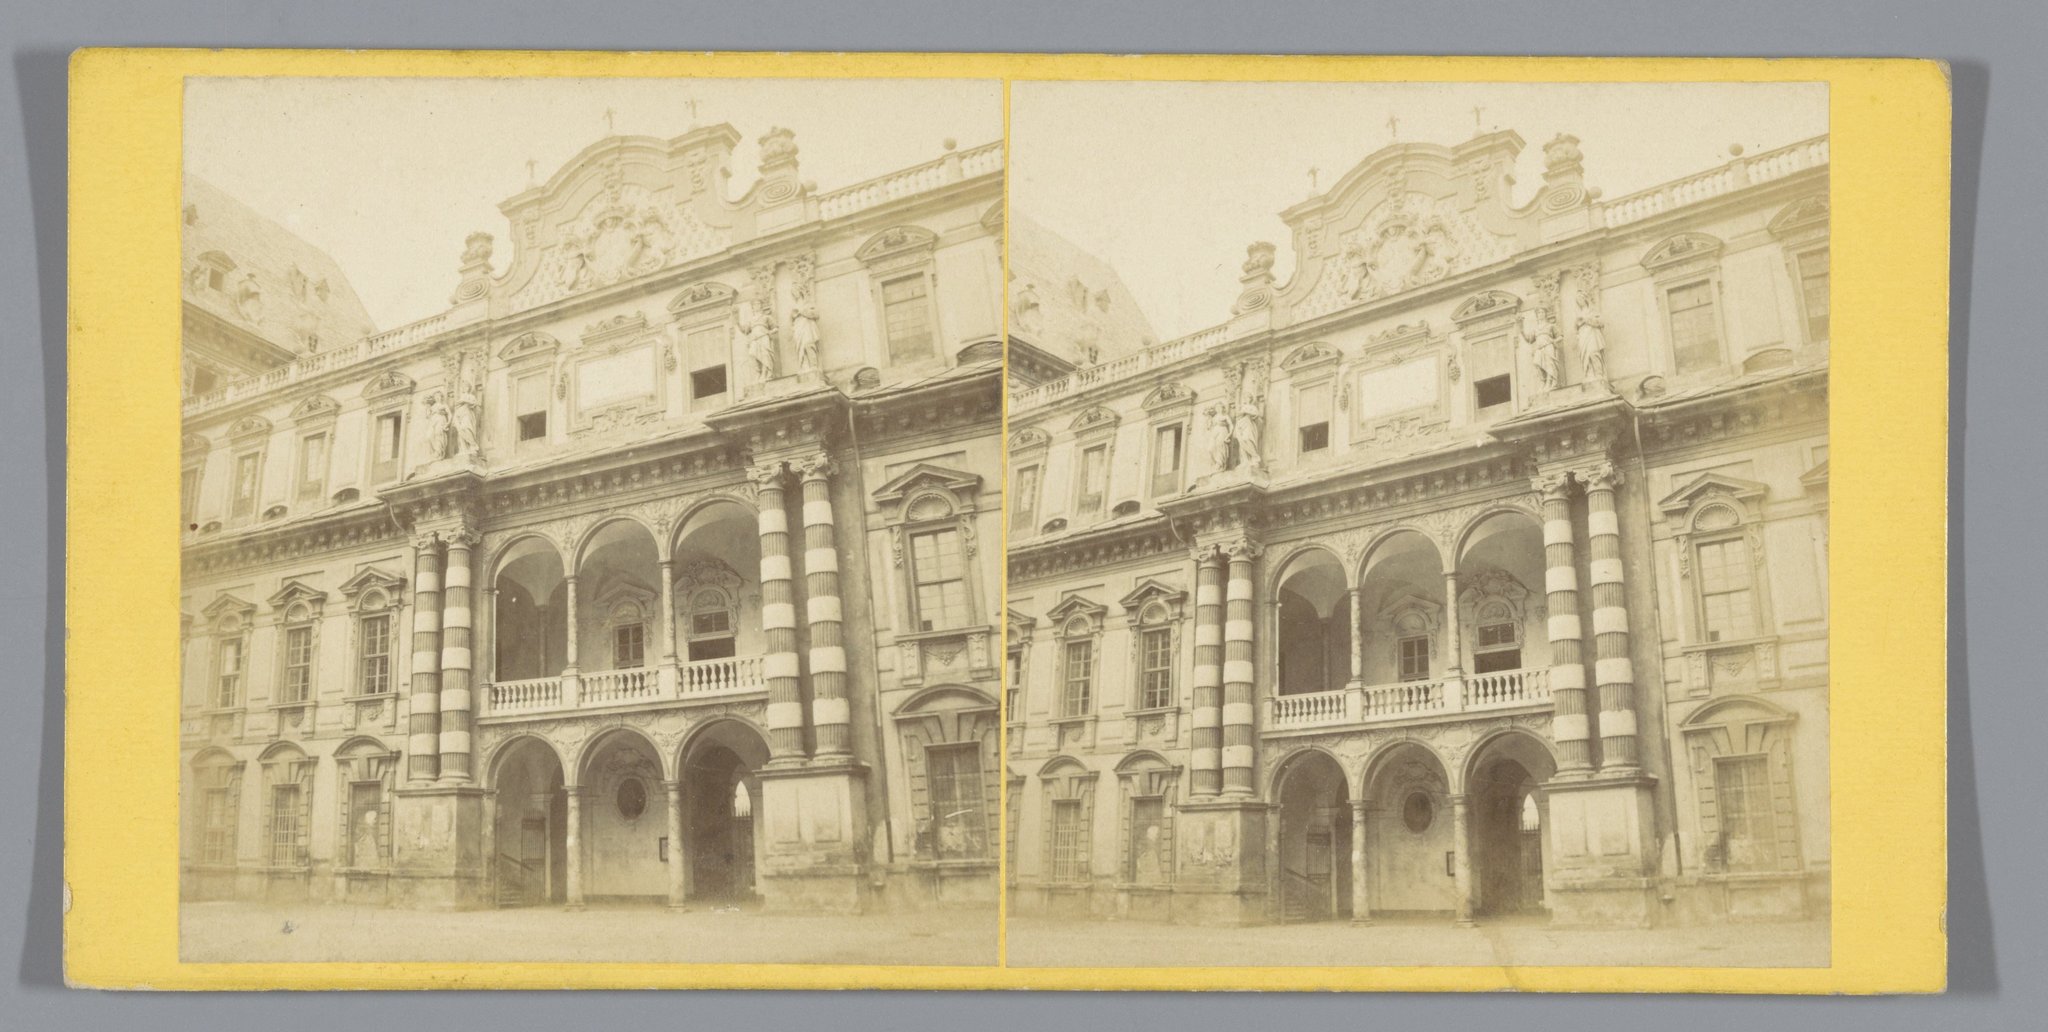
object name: stereograph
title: Valentino (Turin)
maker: Anonymous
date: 1850-1880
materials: cardboard, photographic support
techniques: albumen print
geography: turin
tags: gate, entrance, façade (of house or building)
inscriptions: number: ‘1168.’